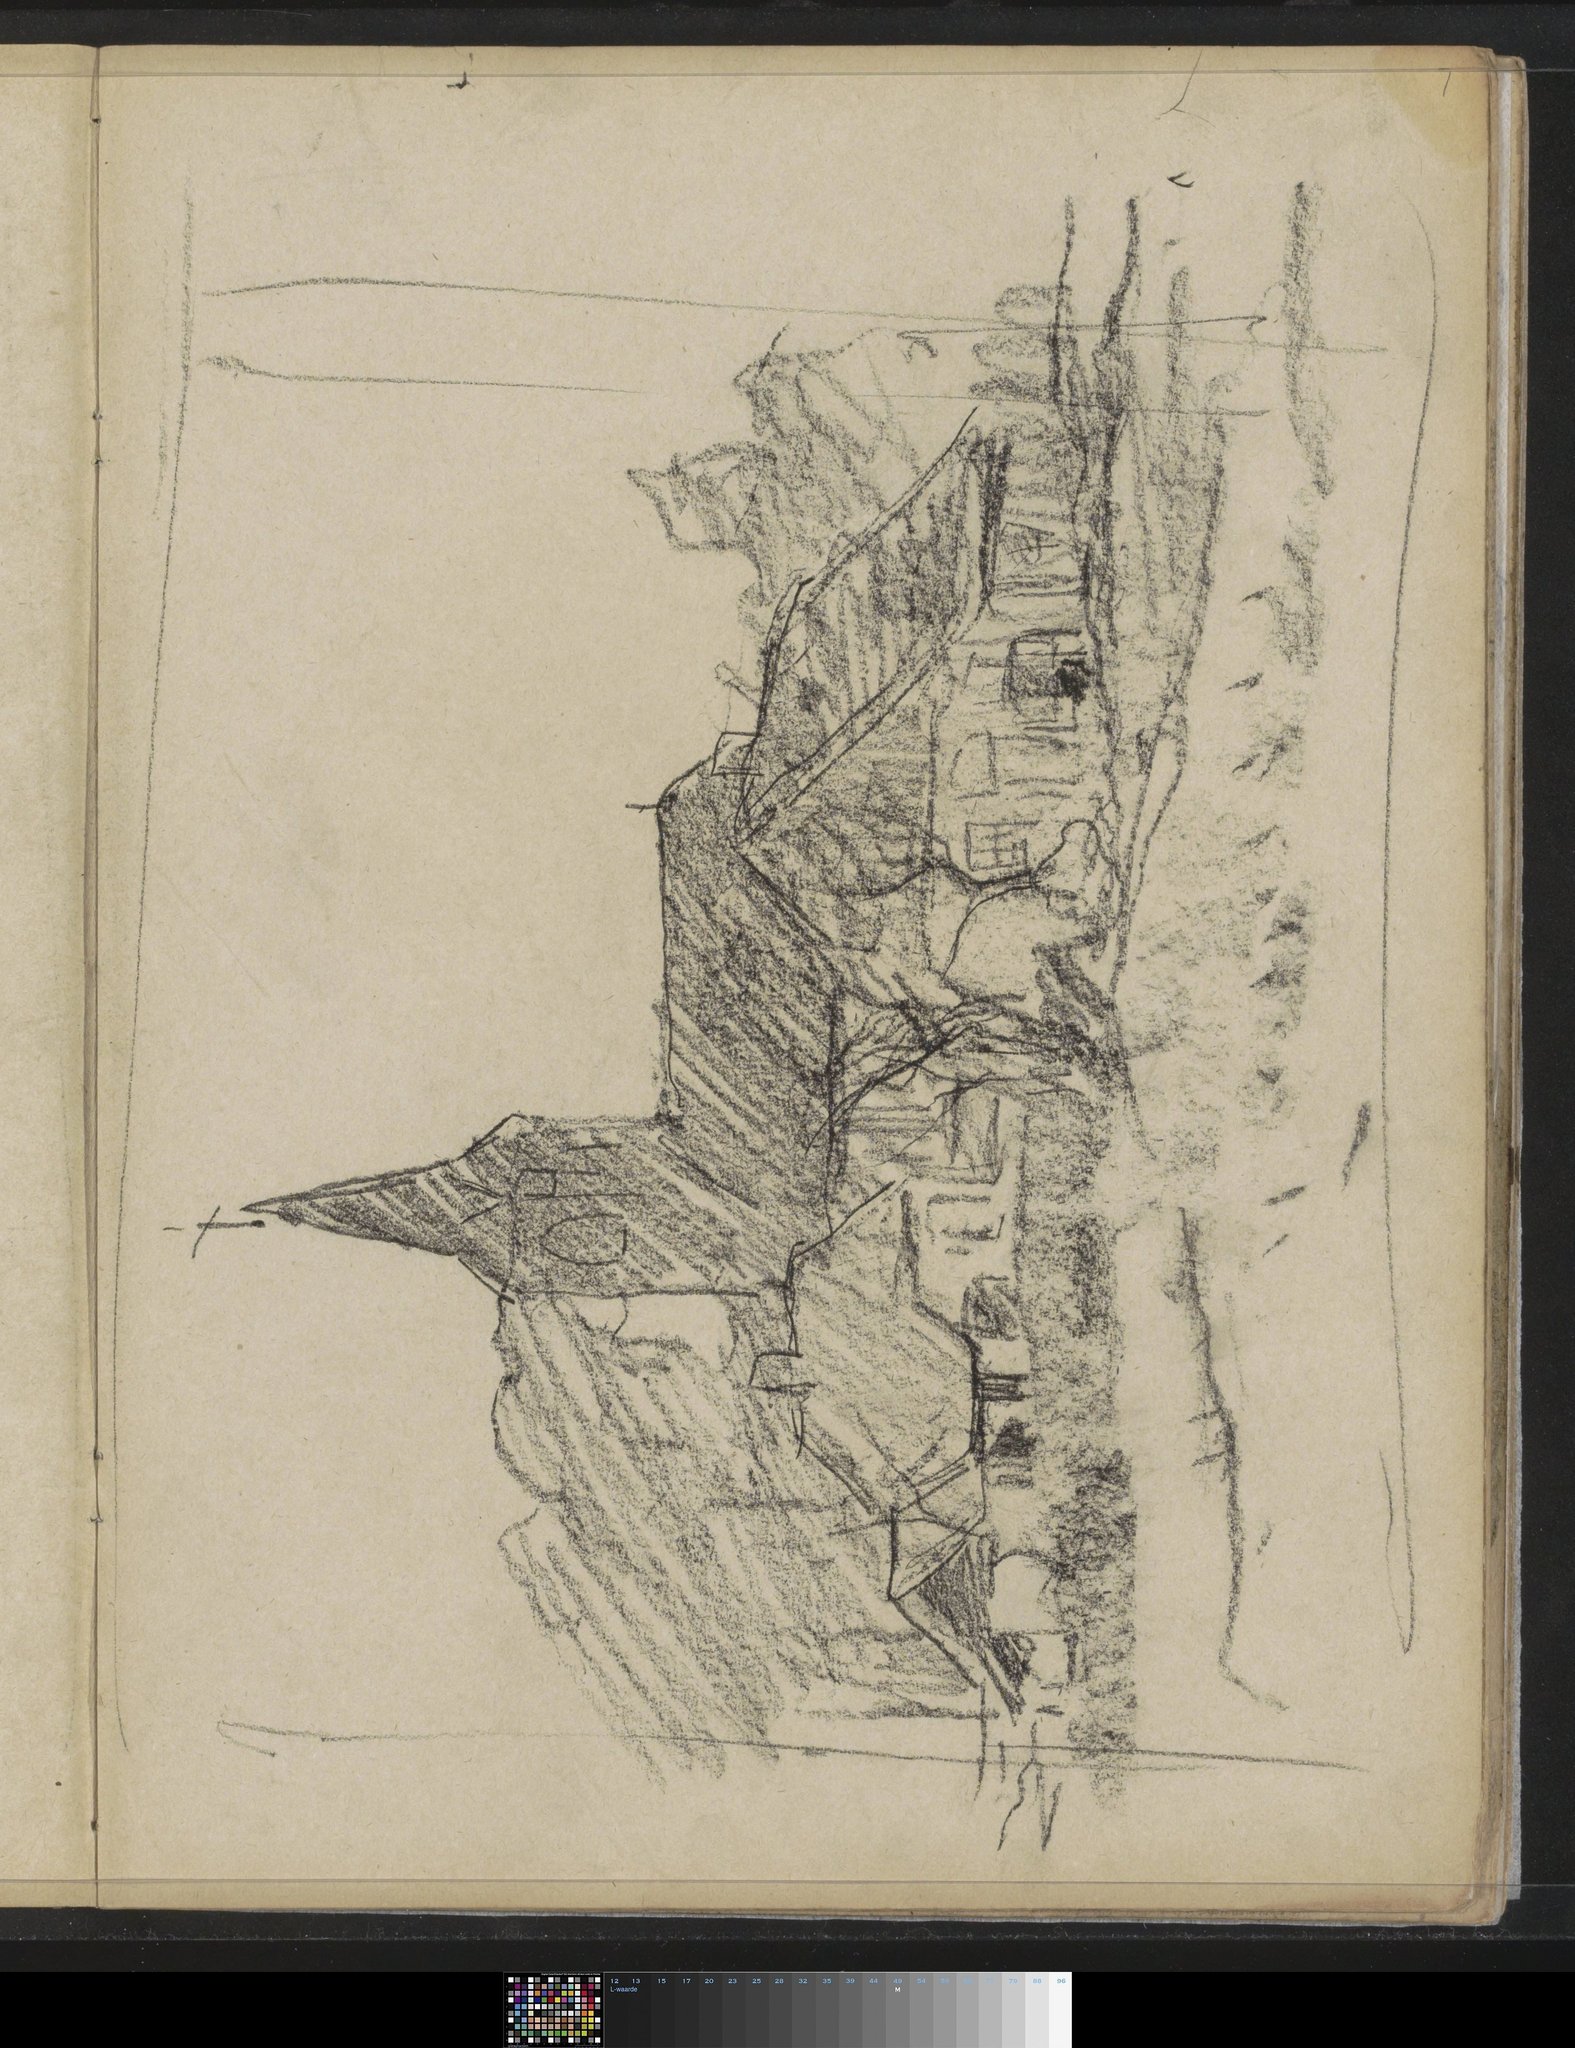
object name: sketchbook leaf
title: Gezicht op Diepenheim met de Johanneskerk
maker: willem witsen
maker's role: draughtsman, painter, print maker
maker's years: 1860-1923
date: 1887-1888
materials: chalk, paper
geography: diepenheim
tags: city-view, and landscape with man-made constructions, church (exterior)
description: Pagina 7 uit een schetsboek met 43 bladen.